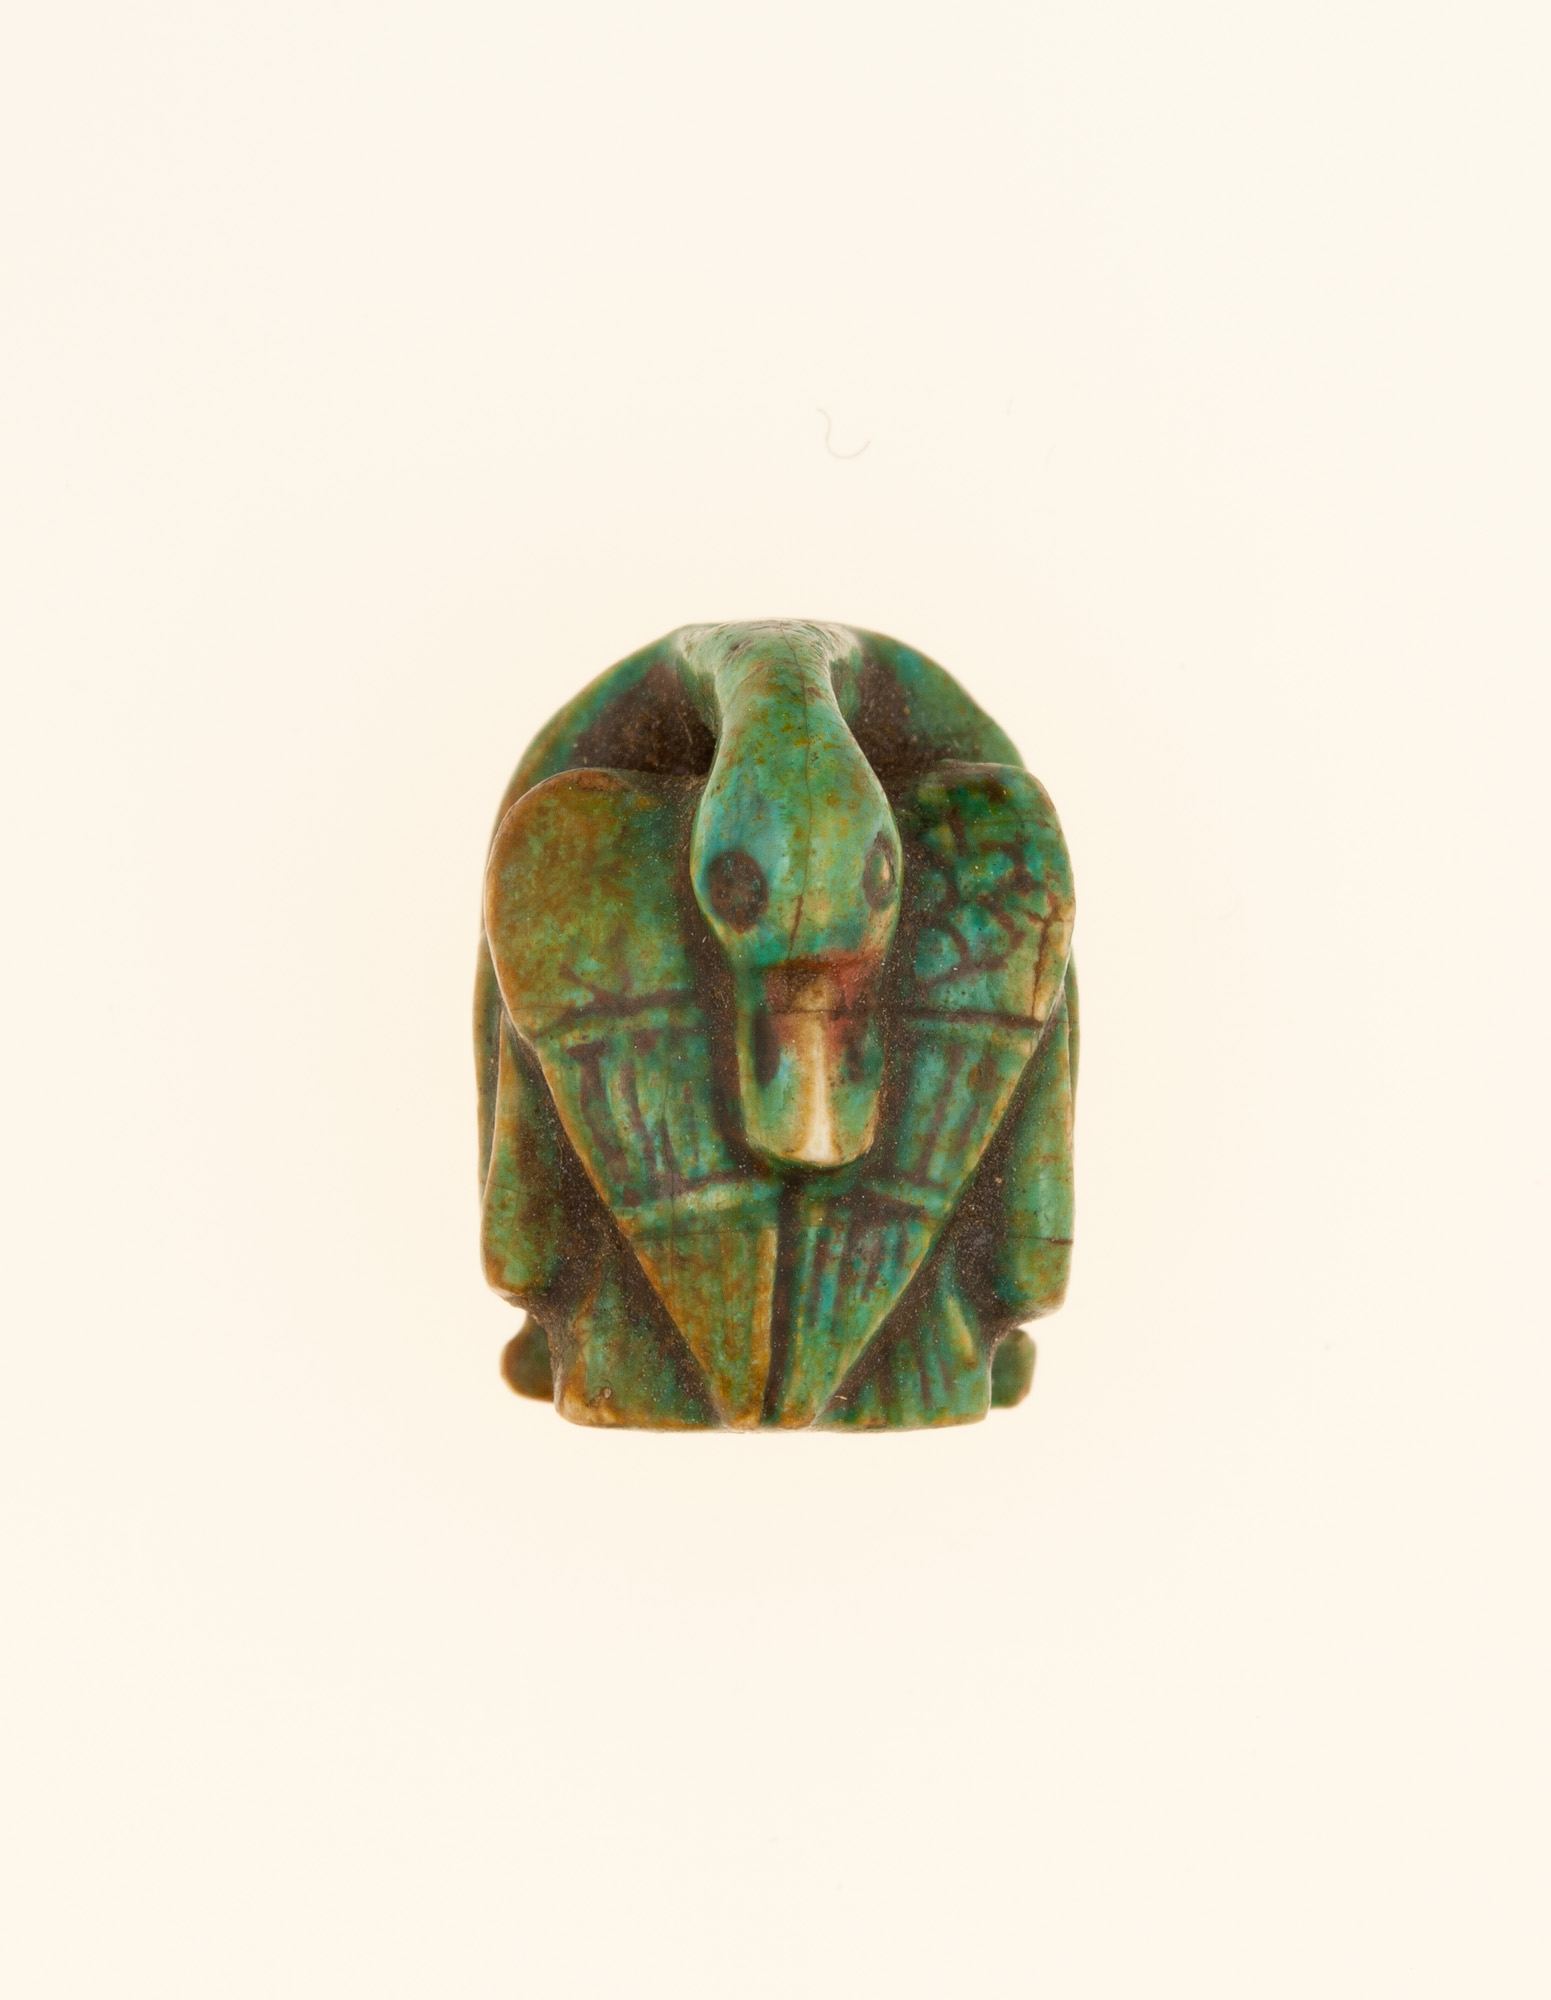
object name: seal, duck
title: Seal in shape of a duck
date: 1550-1450 BCE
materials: stone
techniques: glazing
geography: egypt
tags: ducks